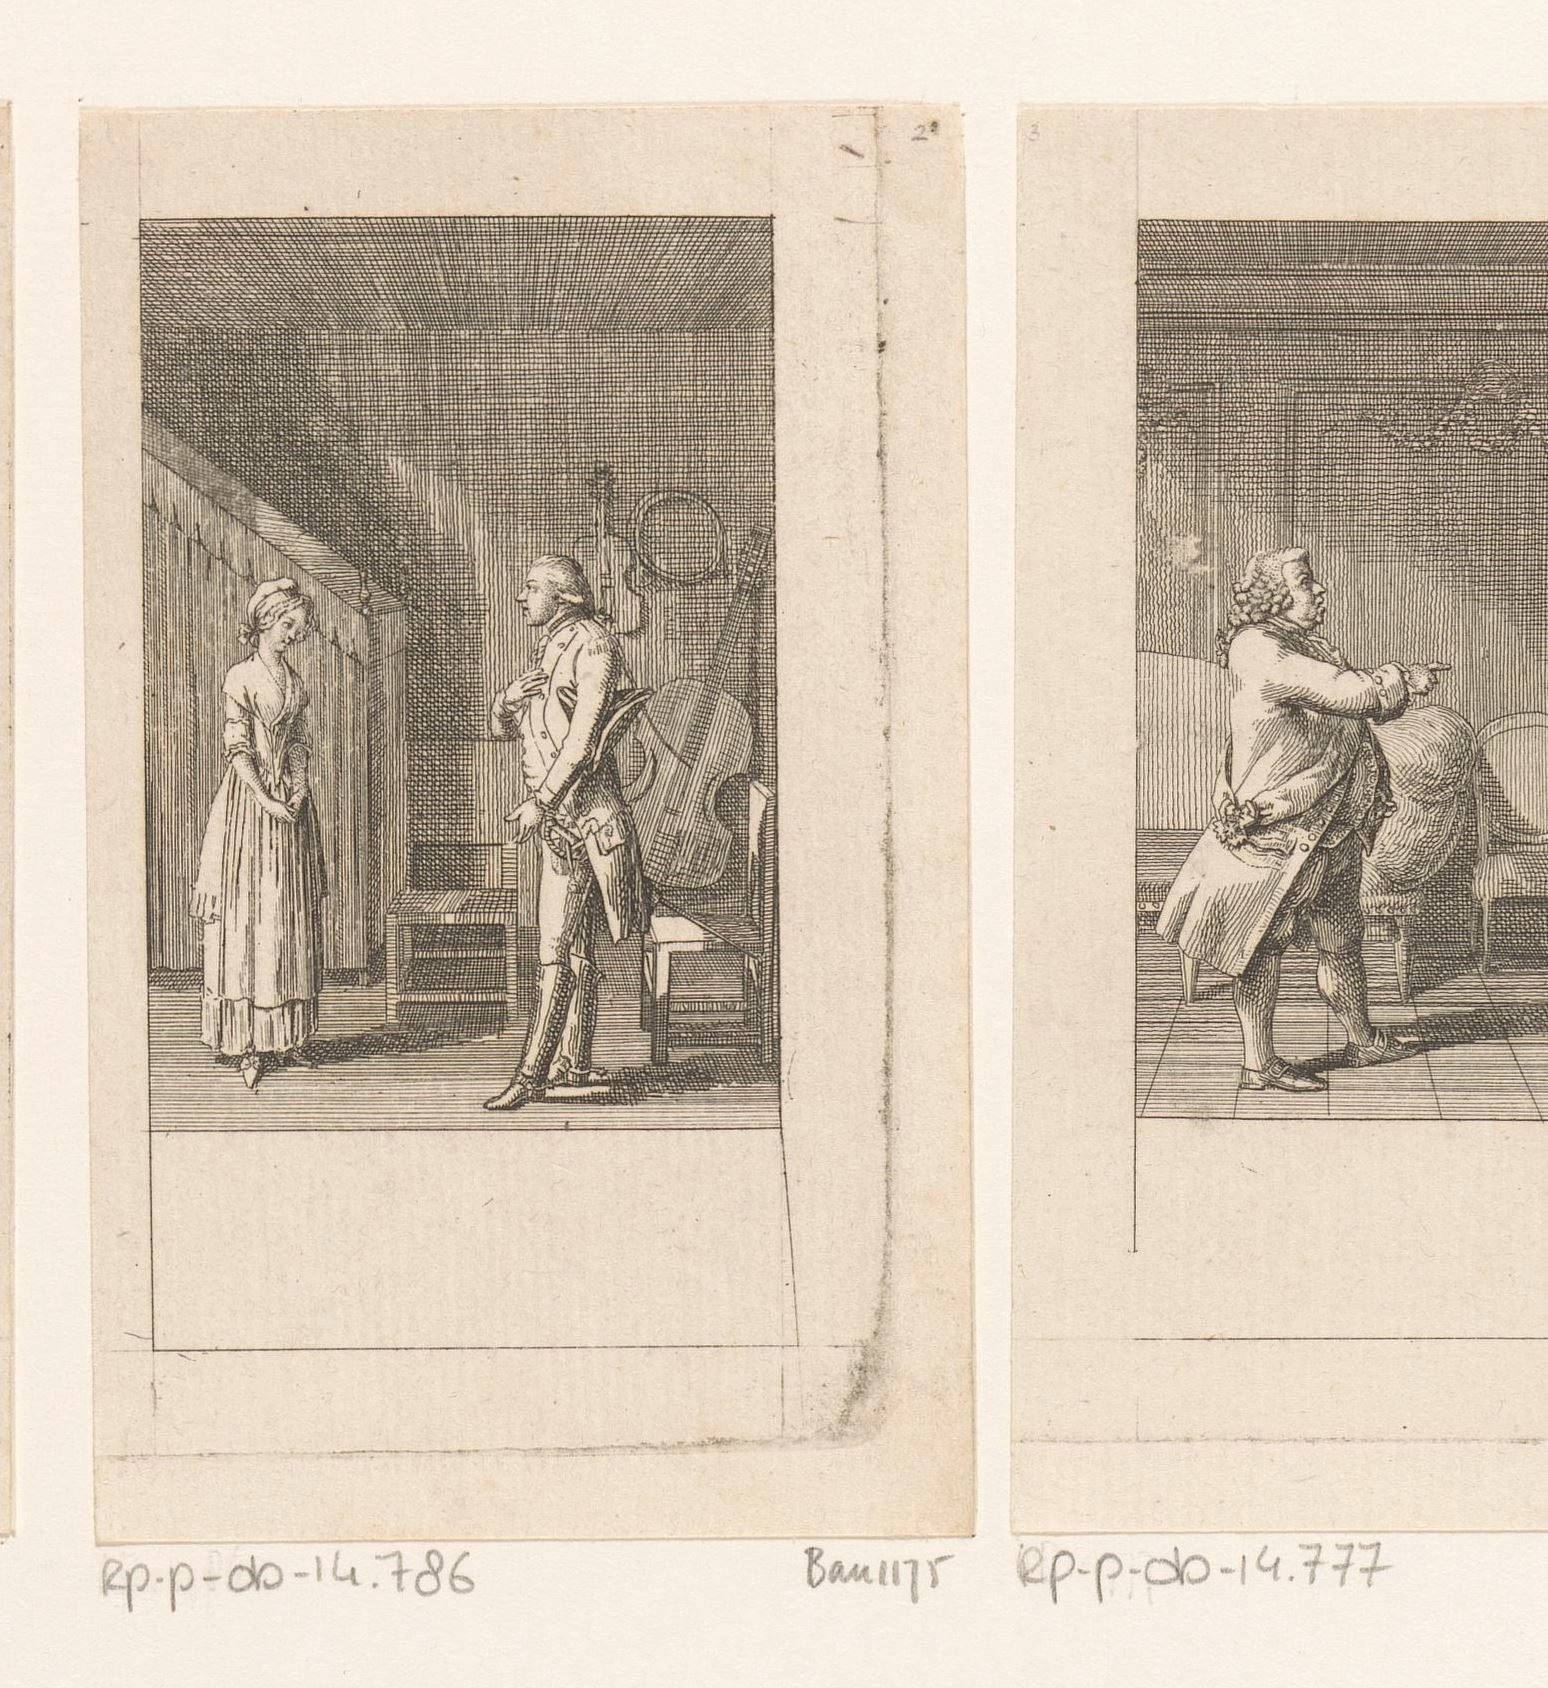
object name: print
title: Ferdinand belooft Luise tot zijn vrouw te maken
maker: daniel nikolaus chodowiecki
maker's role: draughtsman, print maker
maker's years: 1726-1801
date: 1785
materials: paper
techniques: etching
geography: berlin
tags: literature, viola, violoncello; double bass, proposal, declaration of love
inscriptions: collector's mark: Lugt 2228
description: Vervaardigd voor Friedrich von Schiller 'Kabale und Liebe'. Latere staat gebruikt voor: Königl. Grossbrit. Genealogischer Kalender auf das Jahr 1786. Lauenburg: J. G. Berenberg, 1785.